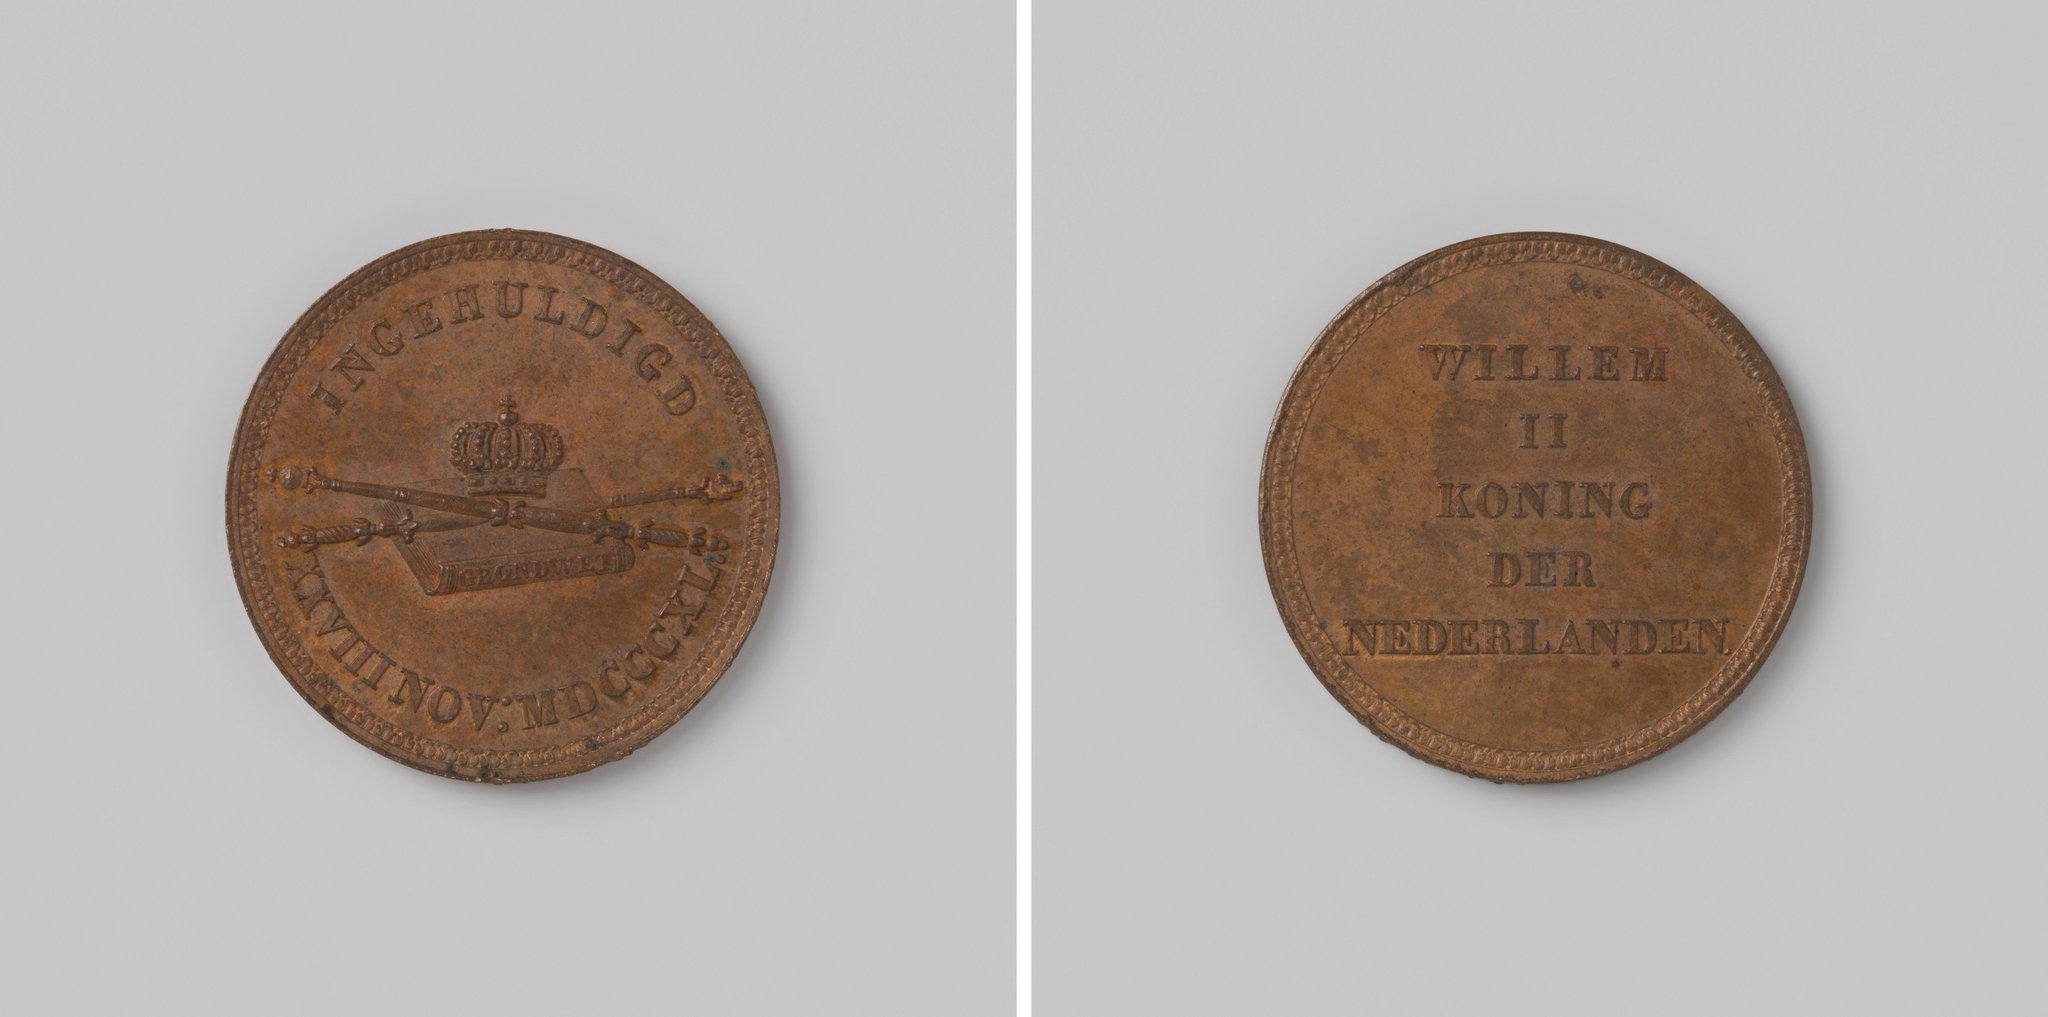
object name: strooipenning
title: Inhuldiging van Willem II, koning der Nederlanden te Amsterdam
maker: Anonymous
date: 1840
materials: bronze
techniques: striking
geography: netherlands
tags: the hague, william ii of the netherlands, amsterdam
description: Bronzen penning. Voorzijde: kroon, liggend op gekruiste scepter en staf, en op boek met opschrift"Grondwet" binnen omschrift. Keerzijde: opschrift